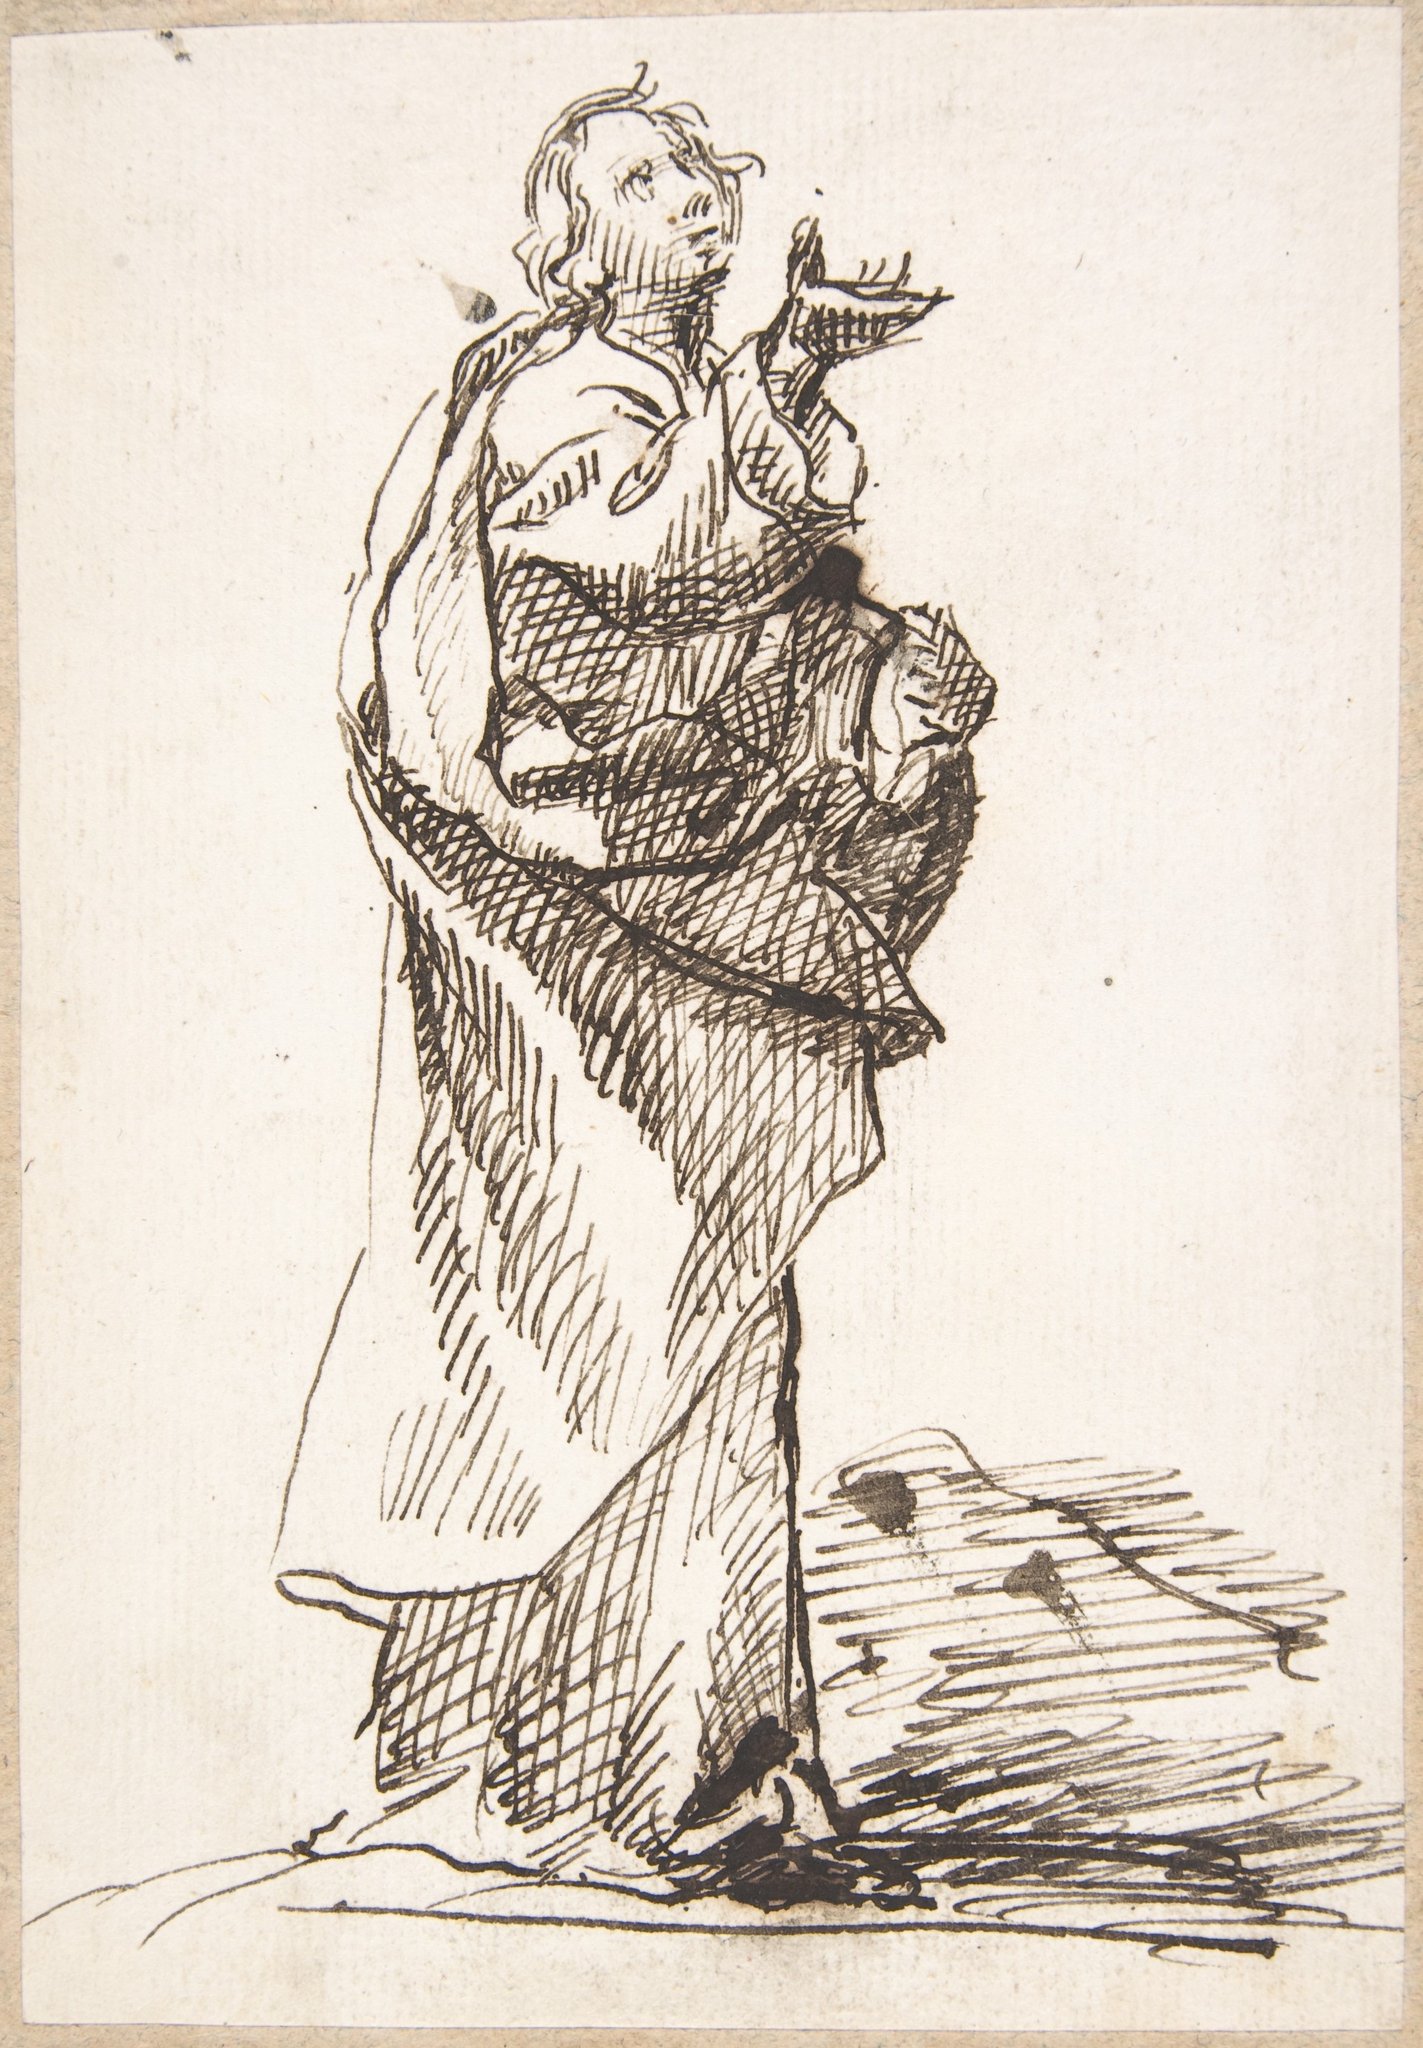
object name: drawing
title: Standing Saint (apostle?)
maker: pedro duque cornejo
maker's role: artist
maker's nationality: spanish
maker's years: 1677-1757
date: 1700-1750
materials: ink, ivory, paper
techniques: pen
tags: hands,men